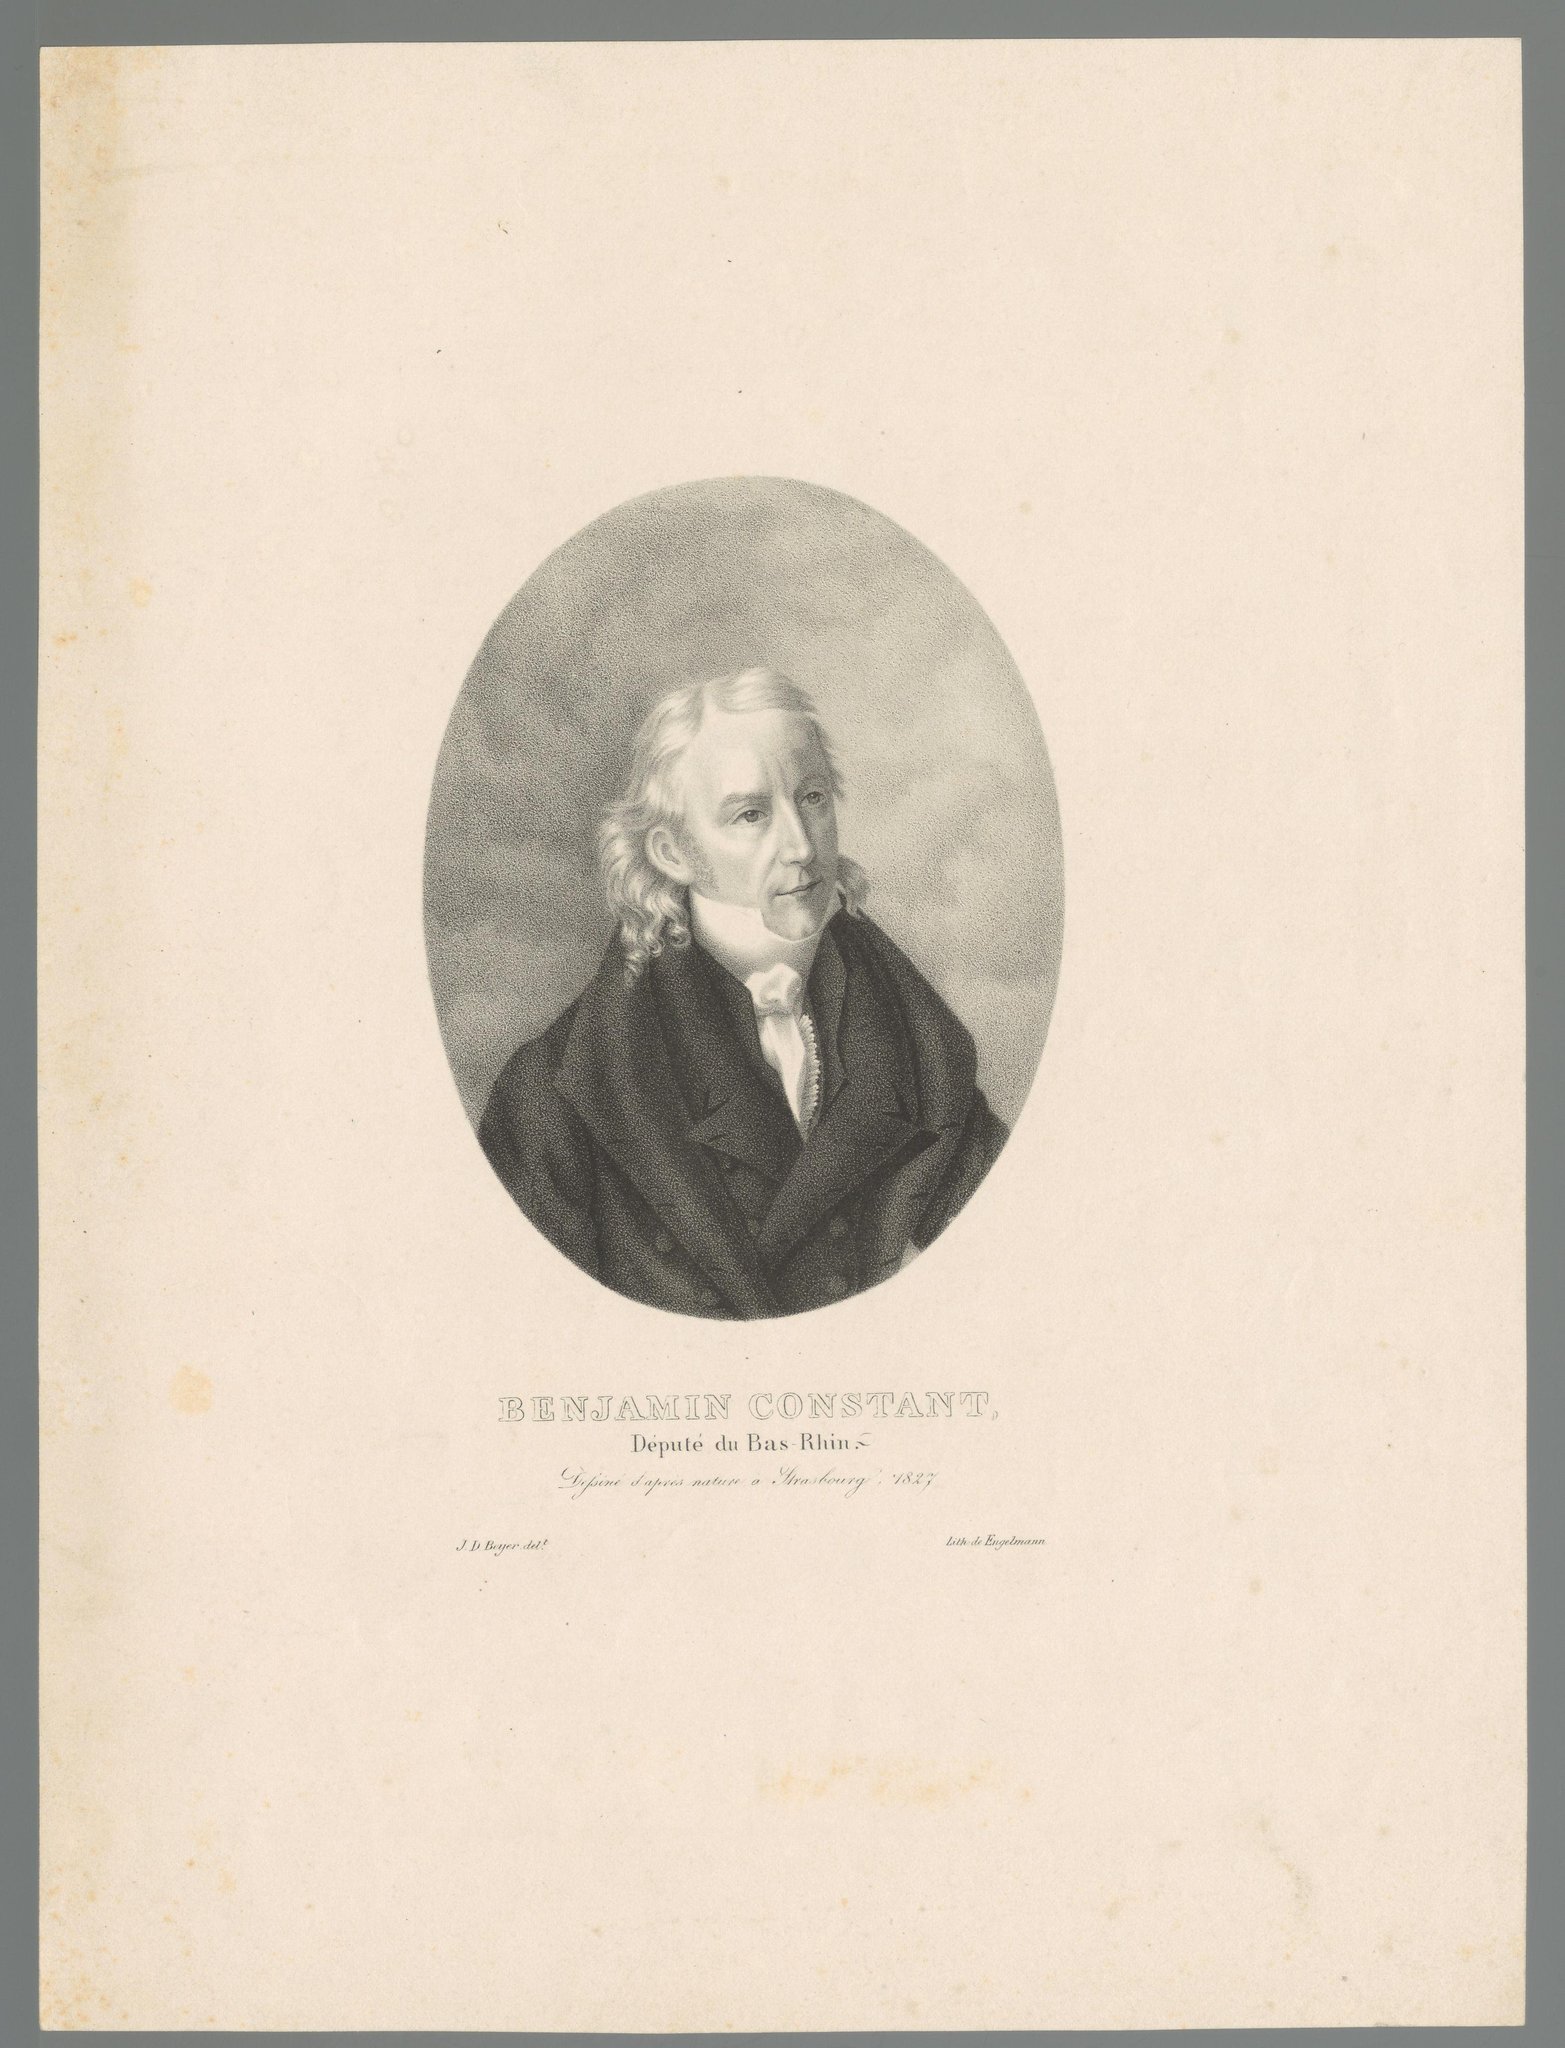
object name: print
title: Portret van Benjamin Constant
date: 1827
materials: paper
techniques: lithograph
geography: straatsburg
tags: paris, politician, adult man, historical persons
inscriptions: collector's mark: Lugt 2228